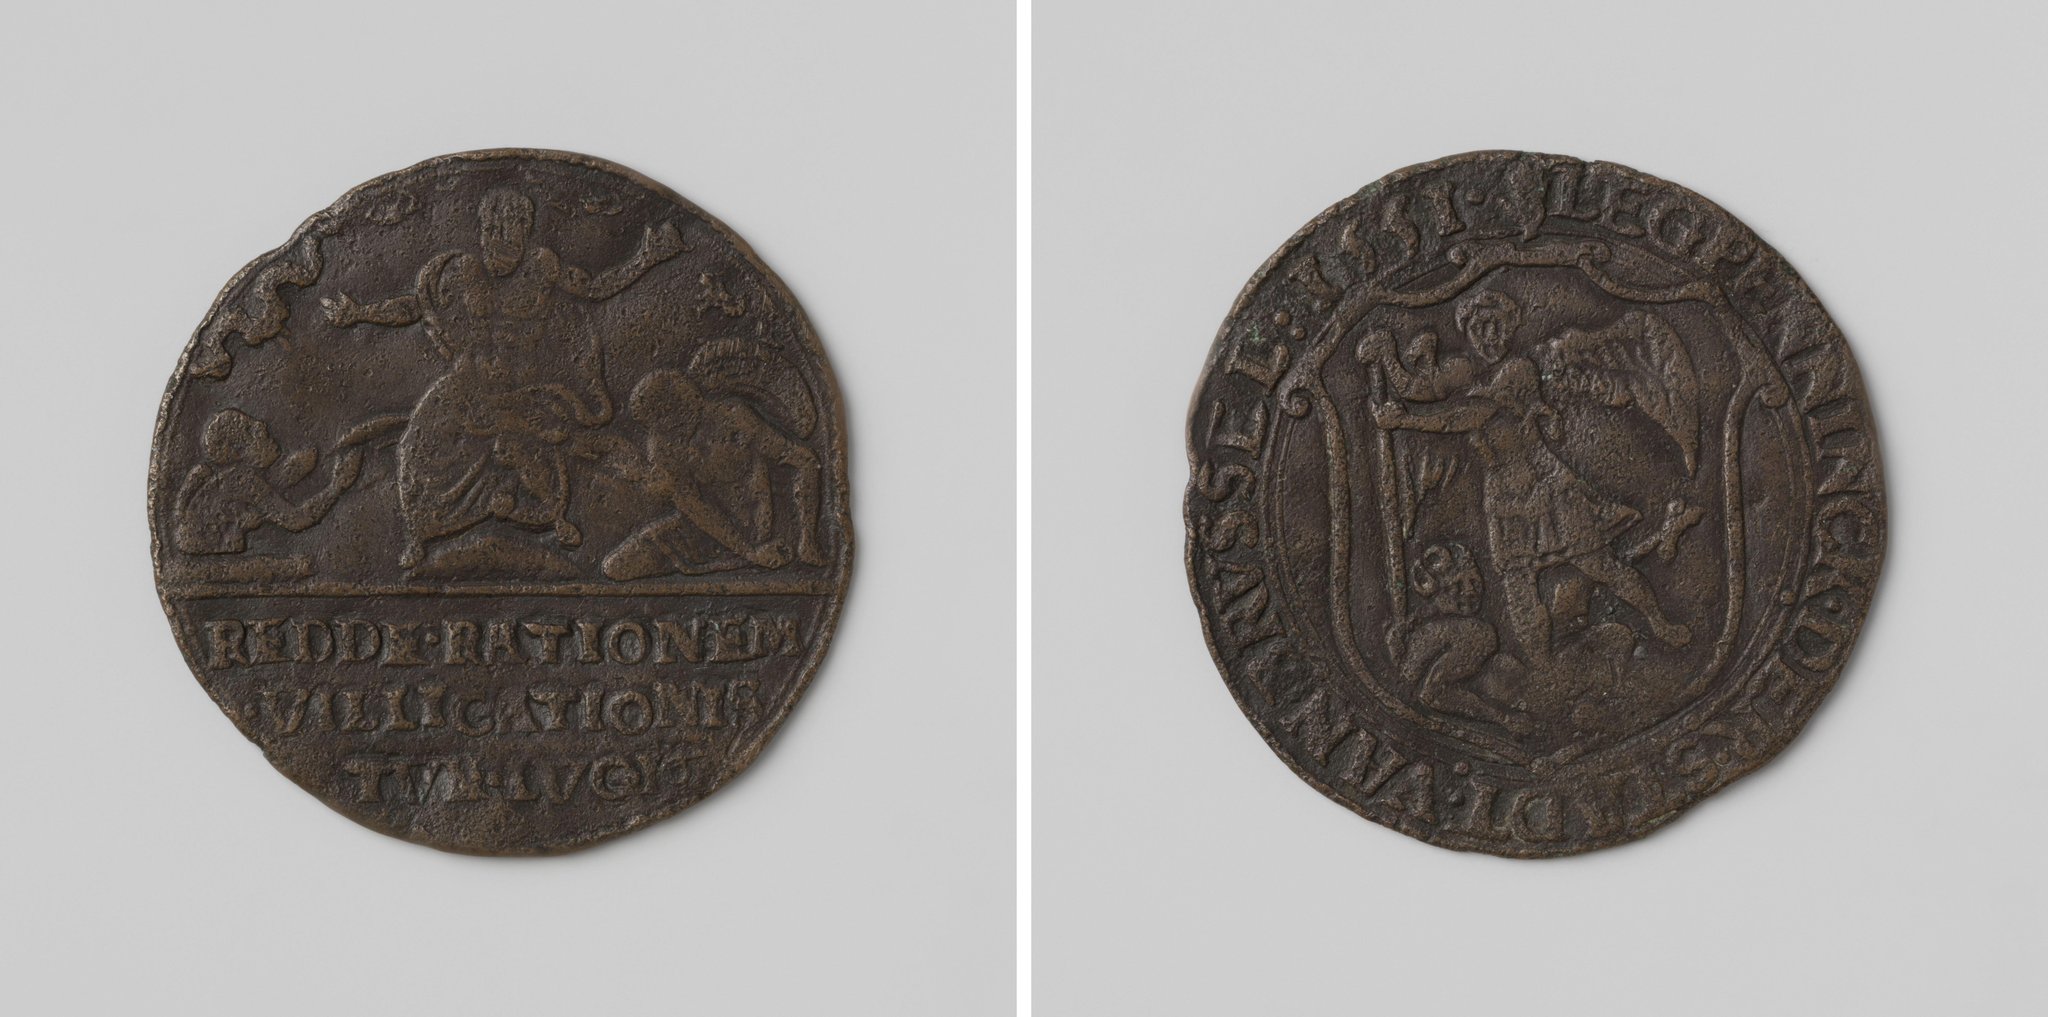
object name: jeton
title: Rekenpenning van de stad Brussel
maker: Anonymous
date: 1551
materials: copper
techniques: striking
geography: antwerp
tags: brussels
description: Koperen penning. Voorzijde: Christus met uitgestrekte handen, staande op wereldbol, geflankeerd door twee mensen; afsnede: opschrift. Keerzijde: wapenschild binnen omschrift